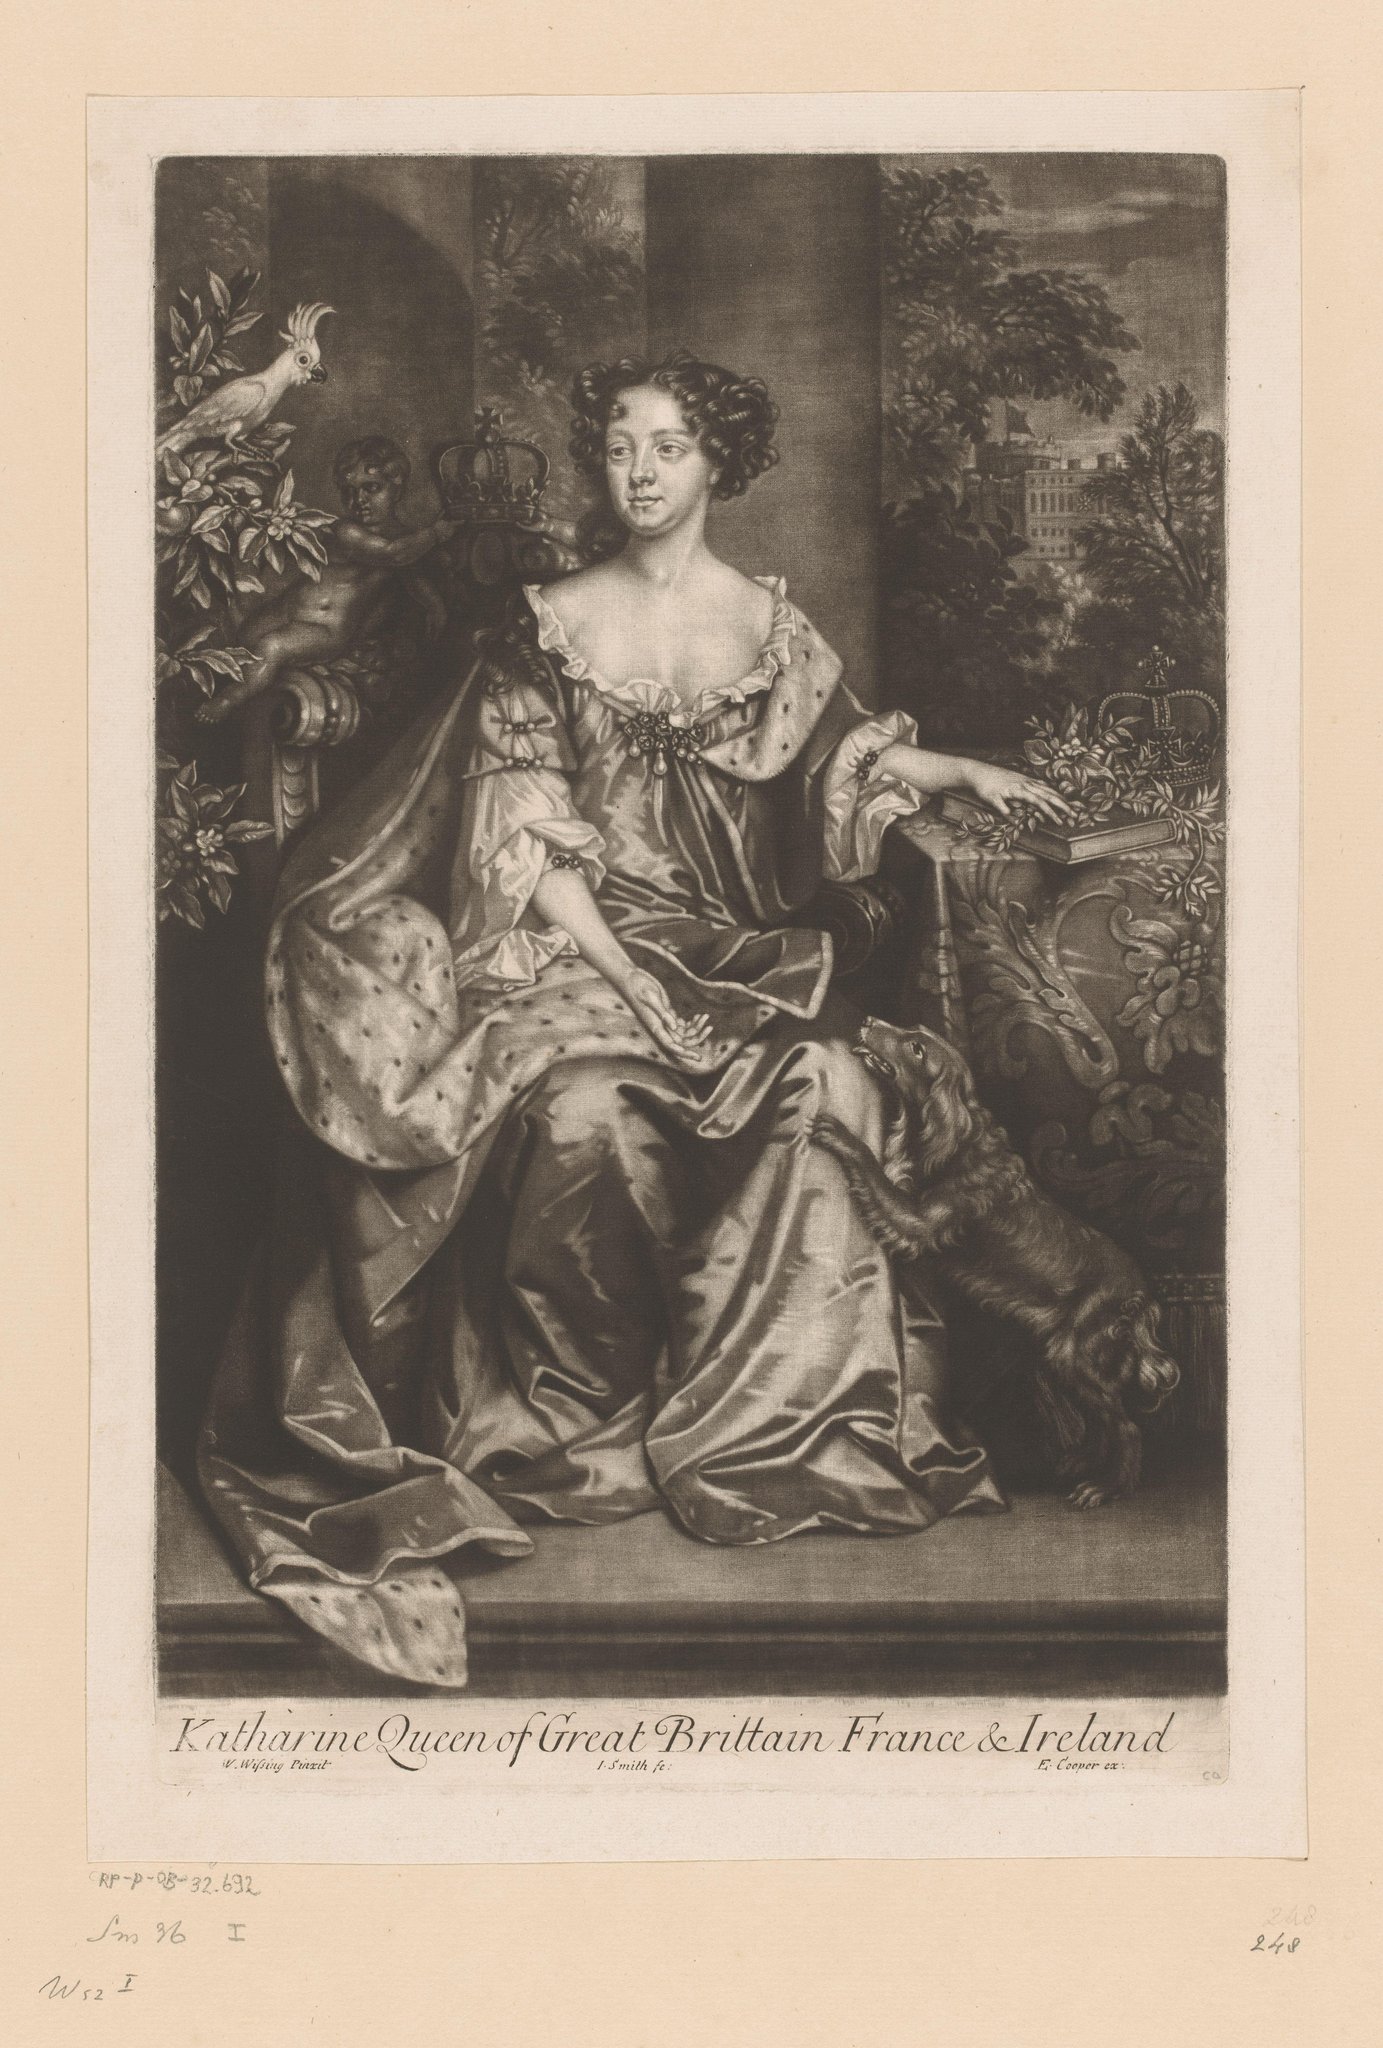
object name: print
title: Portret van Catharina van Bragança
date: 1662-1742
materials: paper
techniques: mezzotint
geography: london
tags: catharina van bragança, ornamental birds: parrot, historical persons, queen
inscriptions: collector's mark: Lugt 240